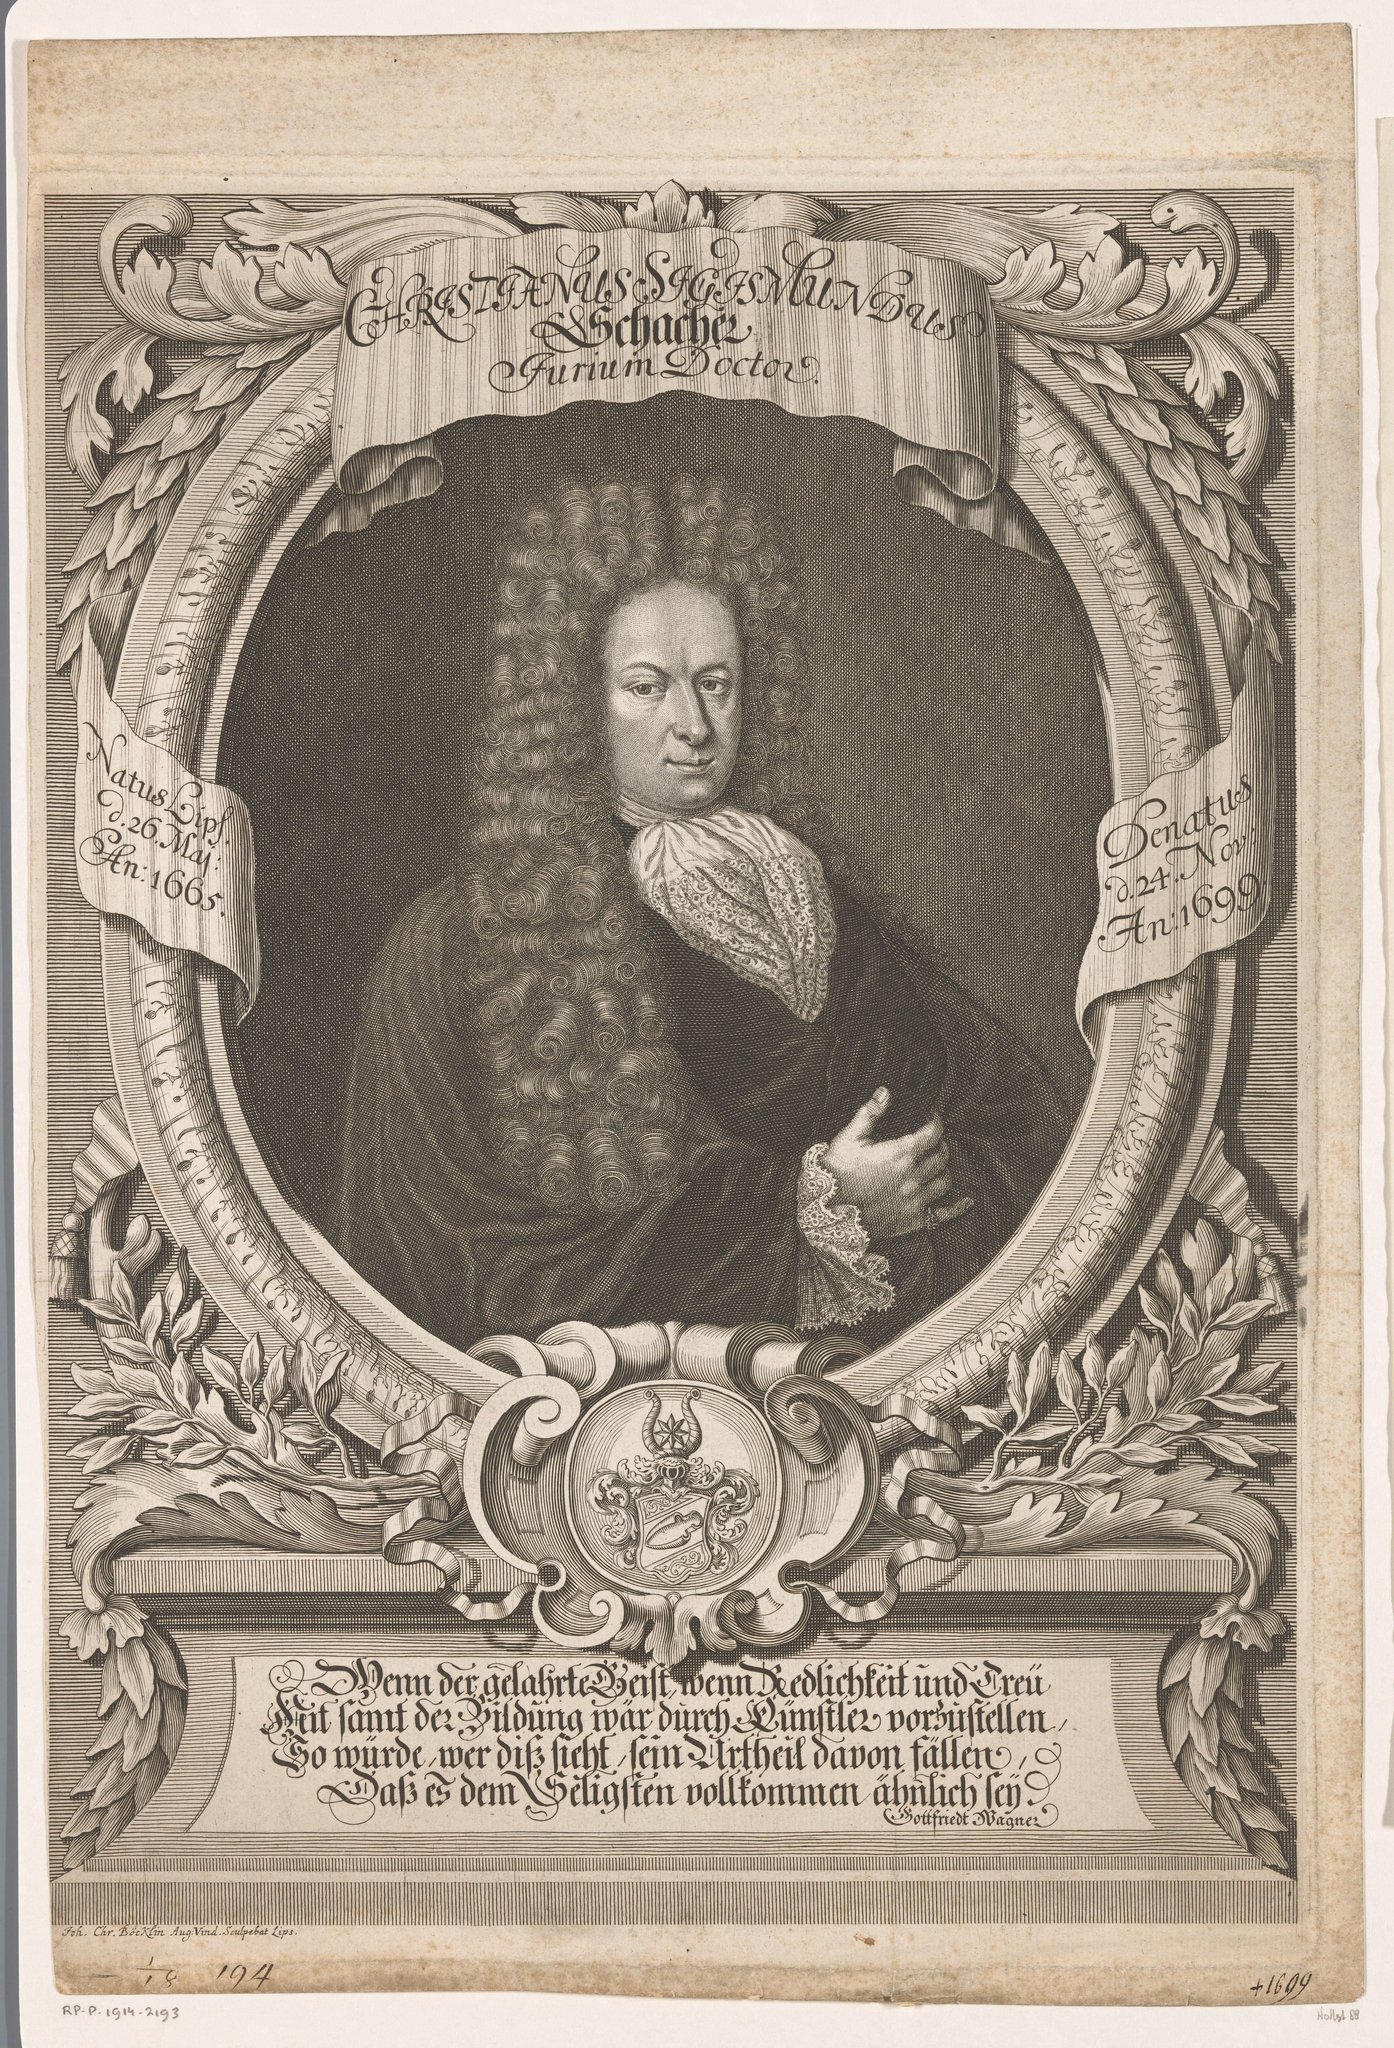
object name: print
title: Portret van Christian Sigismund Schacher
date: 1699-1709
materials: paper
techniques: engraving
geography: leipzig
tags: historical persons, armorial bearing, heraldry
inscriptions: collector's mark: Lugt 2228, collector's mark: Lugt 357